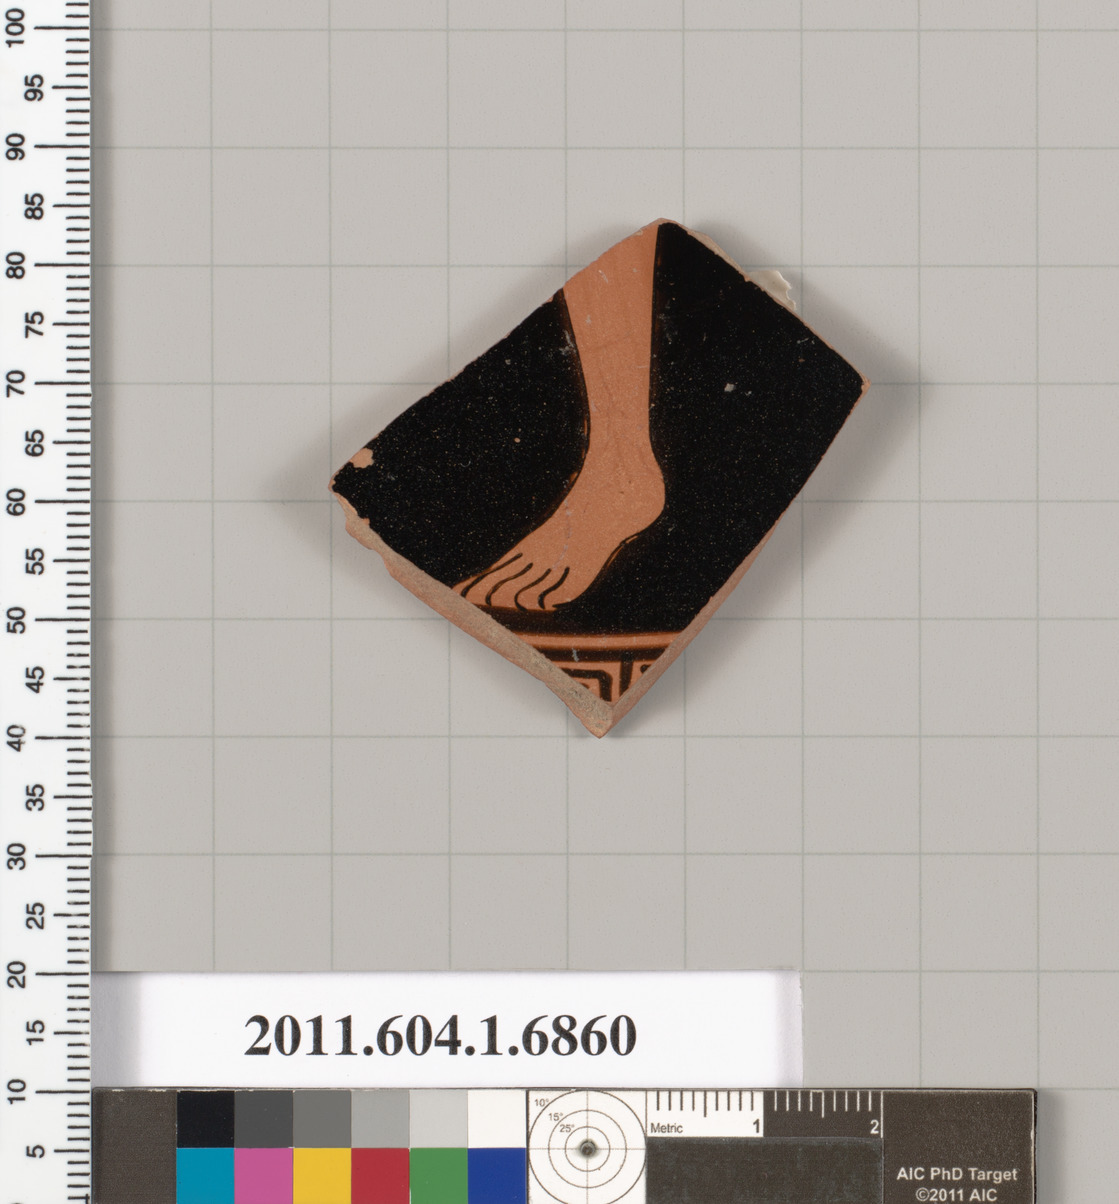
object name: kylix fragment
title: Terracotta fragment of a kylix (drinking cup)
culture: greek, attic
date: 490-470 BCE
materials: terracotta